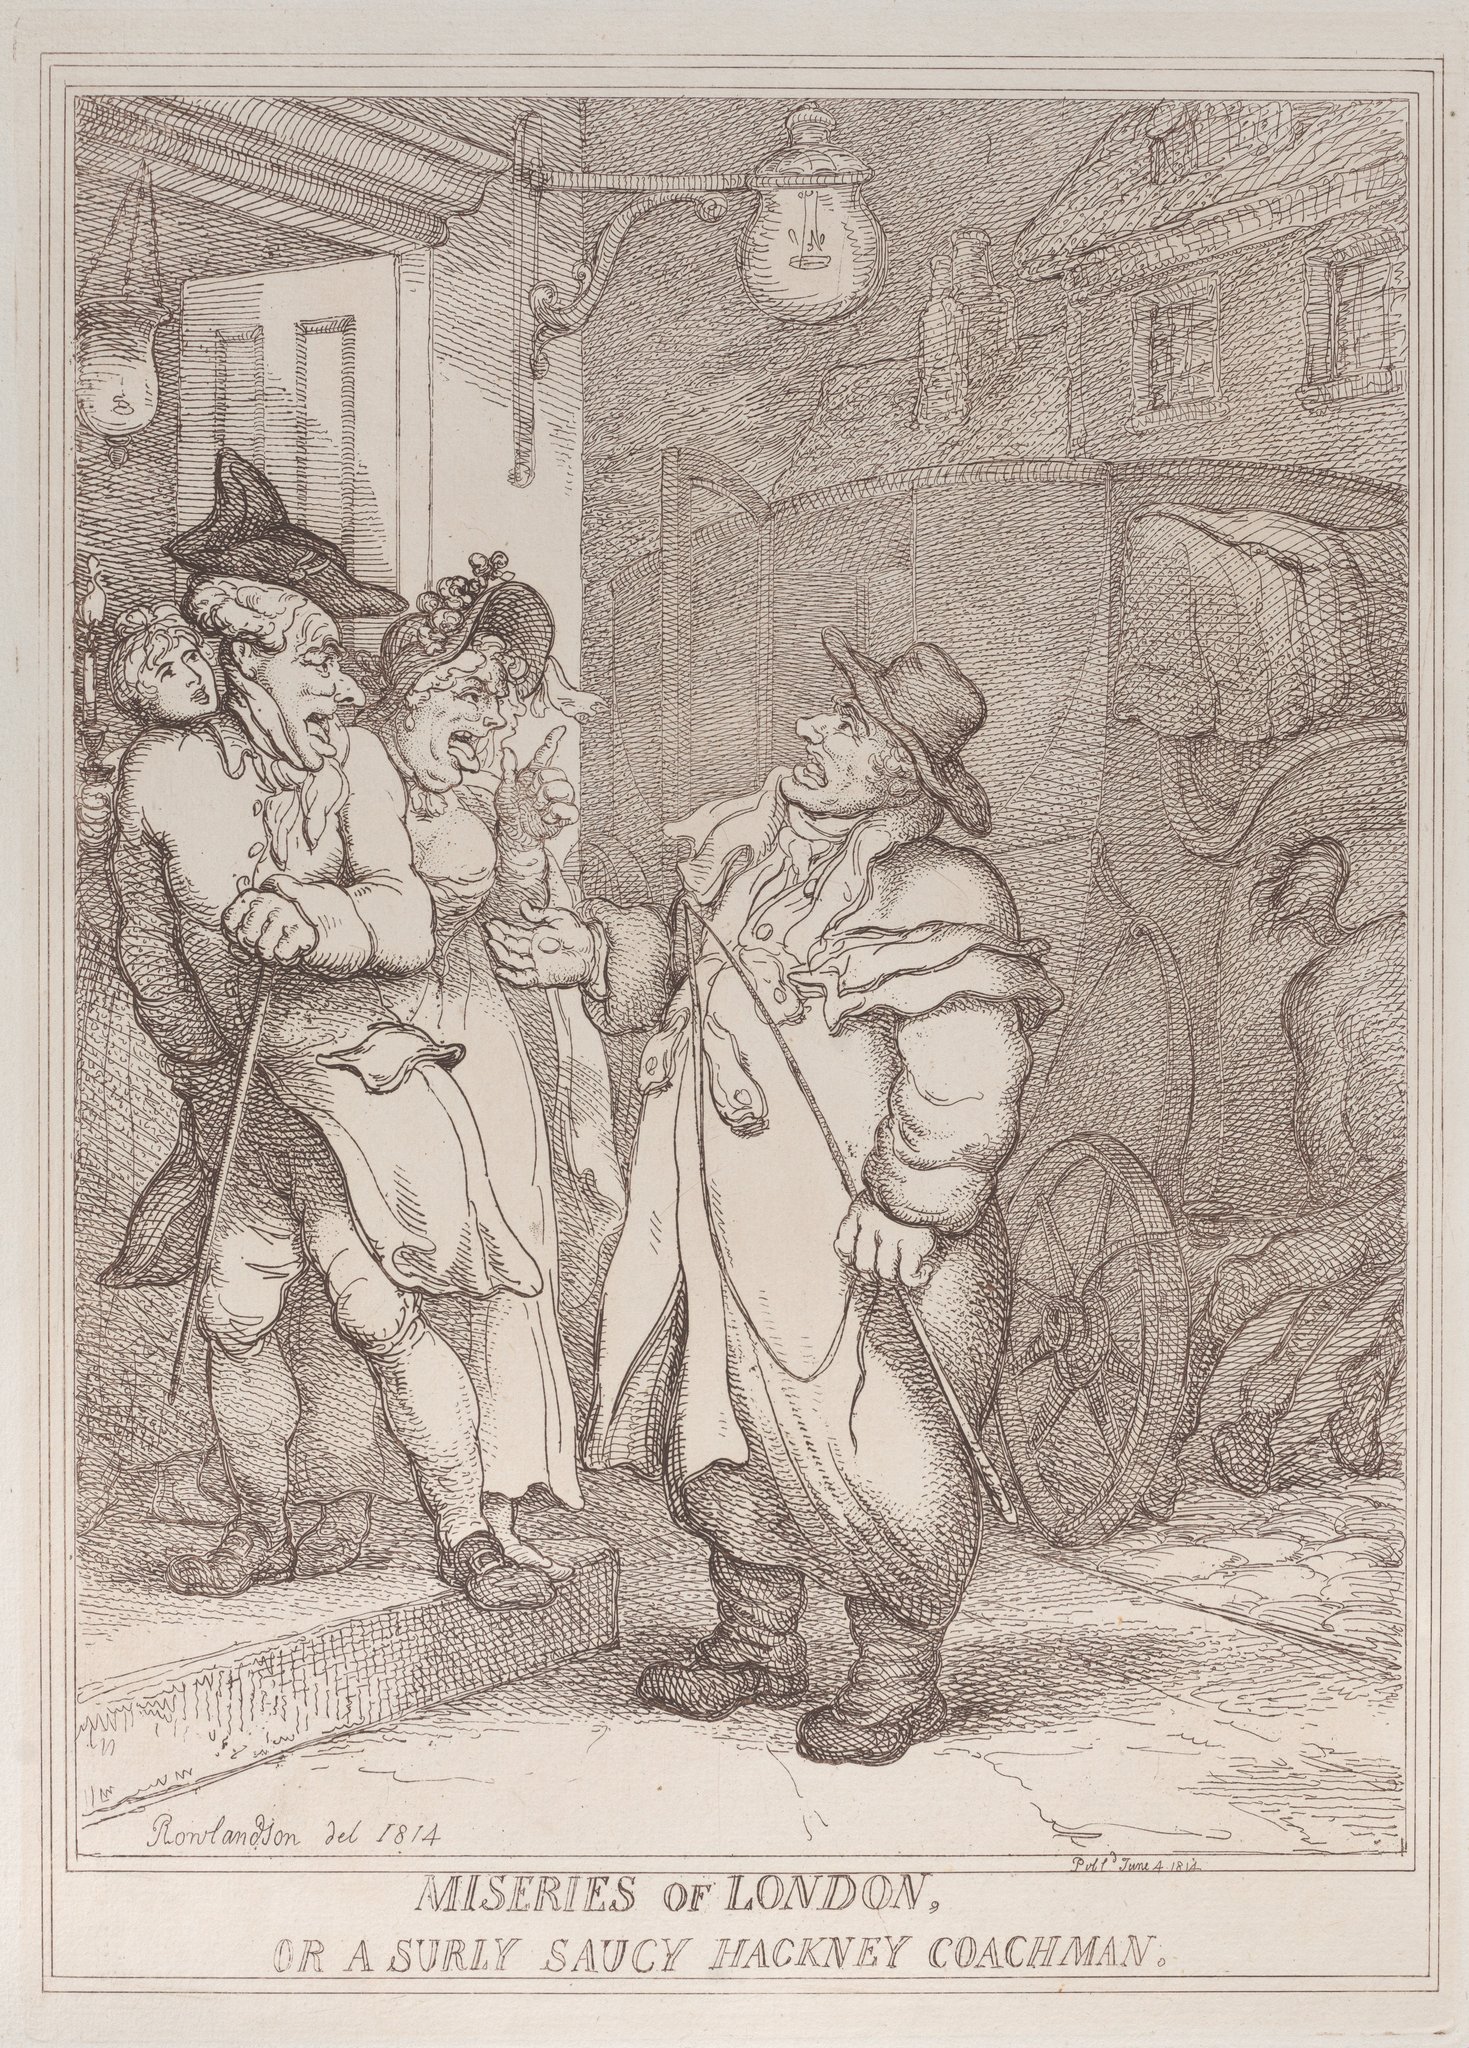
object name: print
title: Miseries of London, or a Surly Saucy Hackney Coachman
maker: thomas rowlandson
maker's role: artist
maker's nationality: british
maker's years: 1757-1827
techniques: etching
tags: satire,men,women